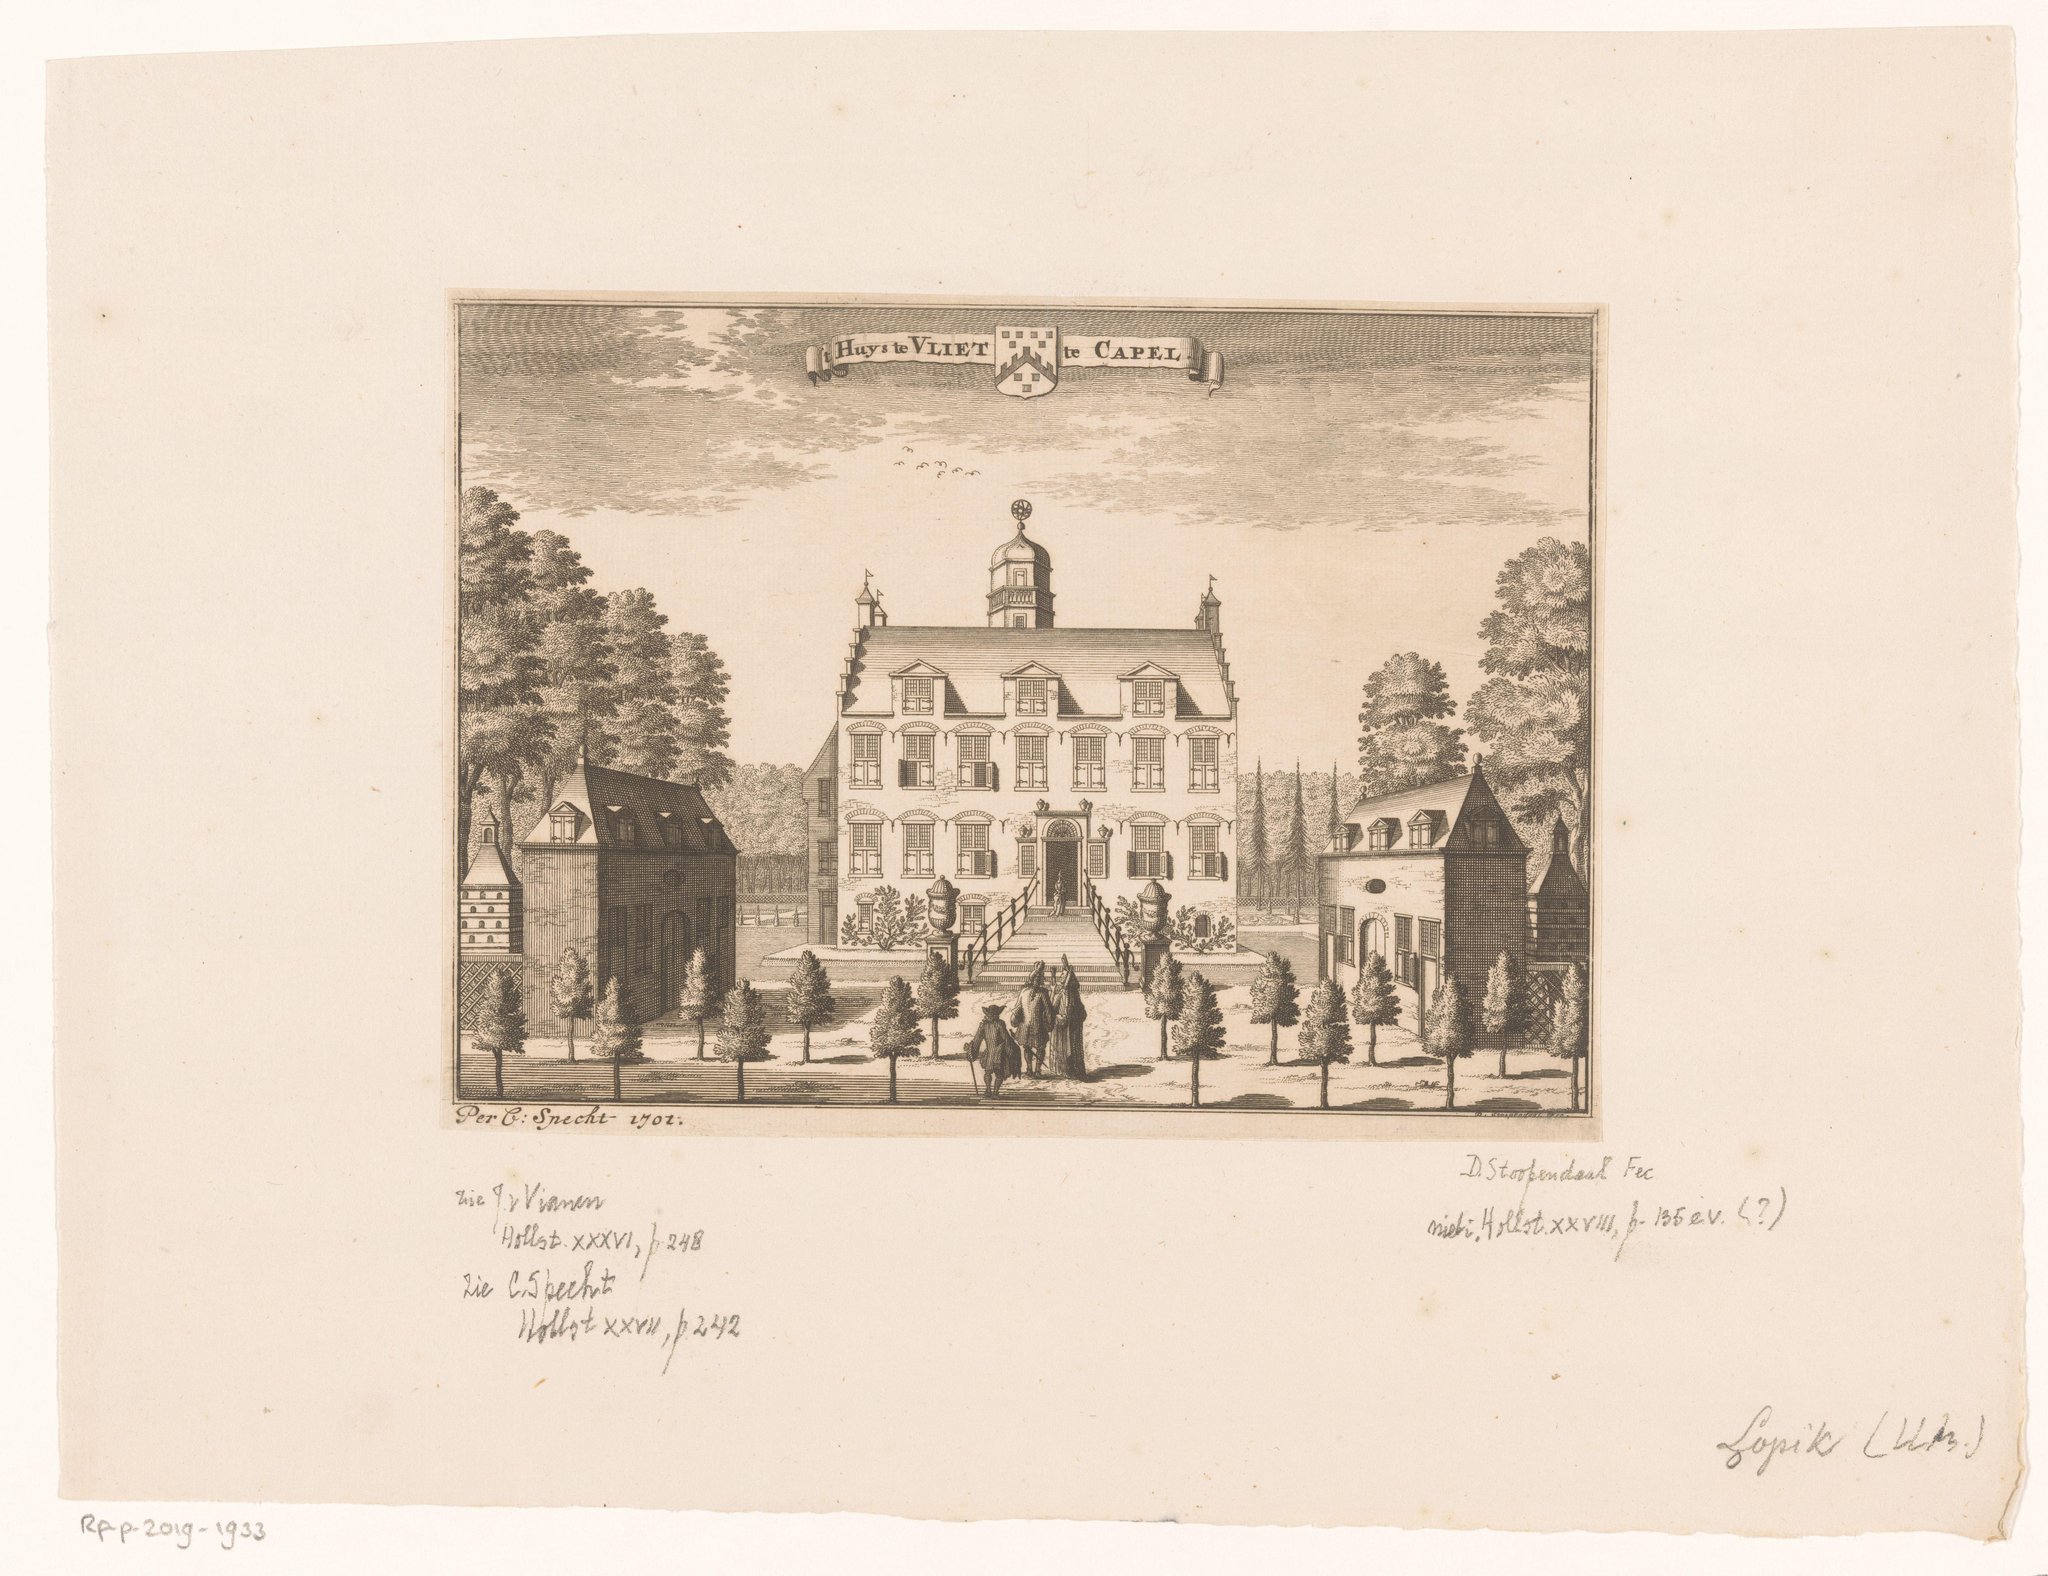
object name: print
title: Huis te Vliet bij Lopikerkapel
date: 1701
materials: paper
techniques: etching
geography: utrecht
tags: rural housing, e.g. country-house, villa, cottage, huis te vliet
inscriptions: date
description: Prent mogelijk uit: Specht, Caspar. Het verheerlykt Utrecht vertoont in de afbeeldingen der adelijke en riddermatige hofteden, in de heerlijkheid van Utrecht. Amsterdam: Reinier en Josua Ottens, s.a.